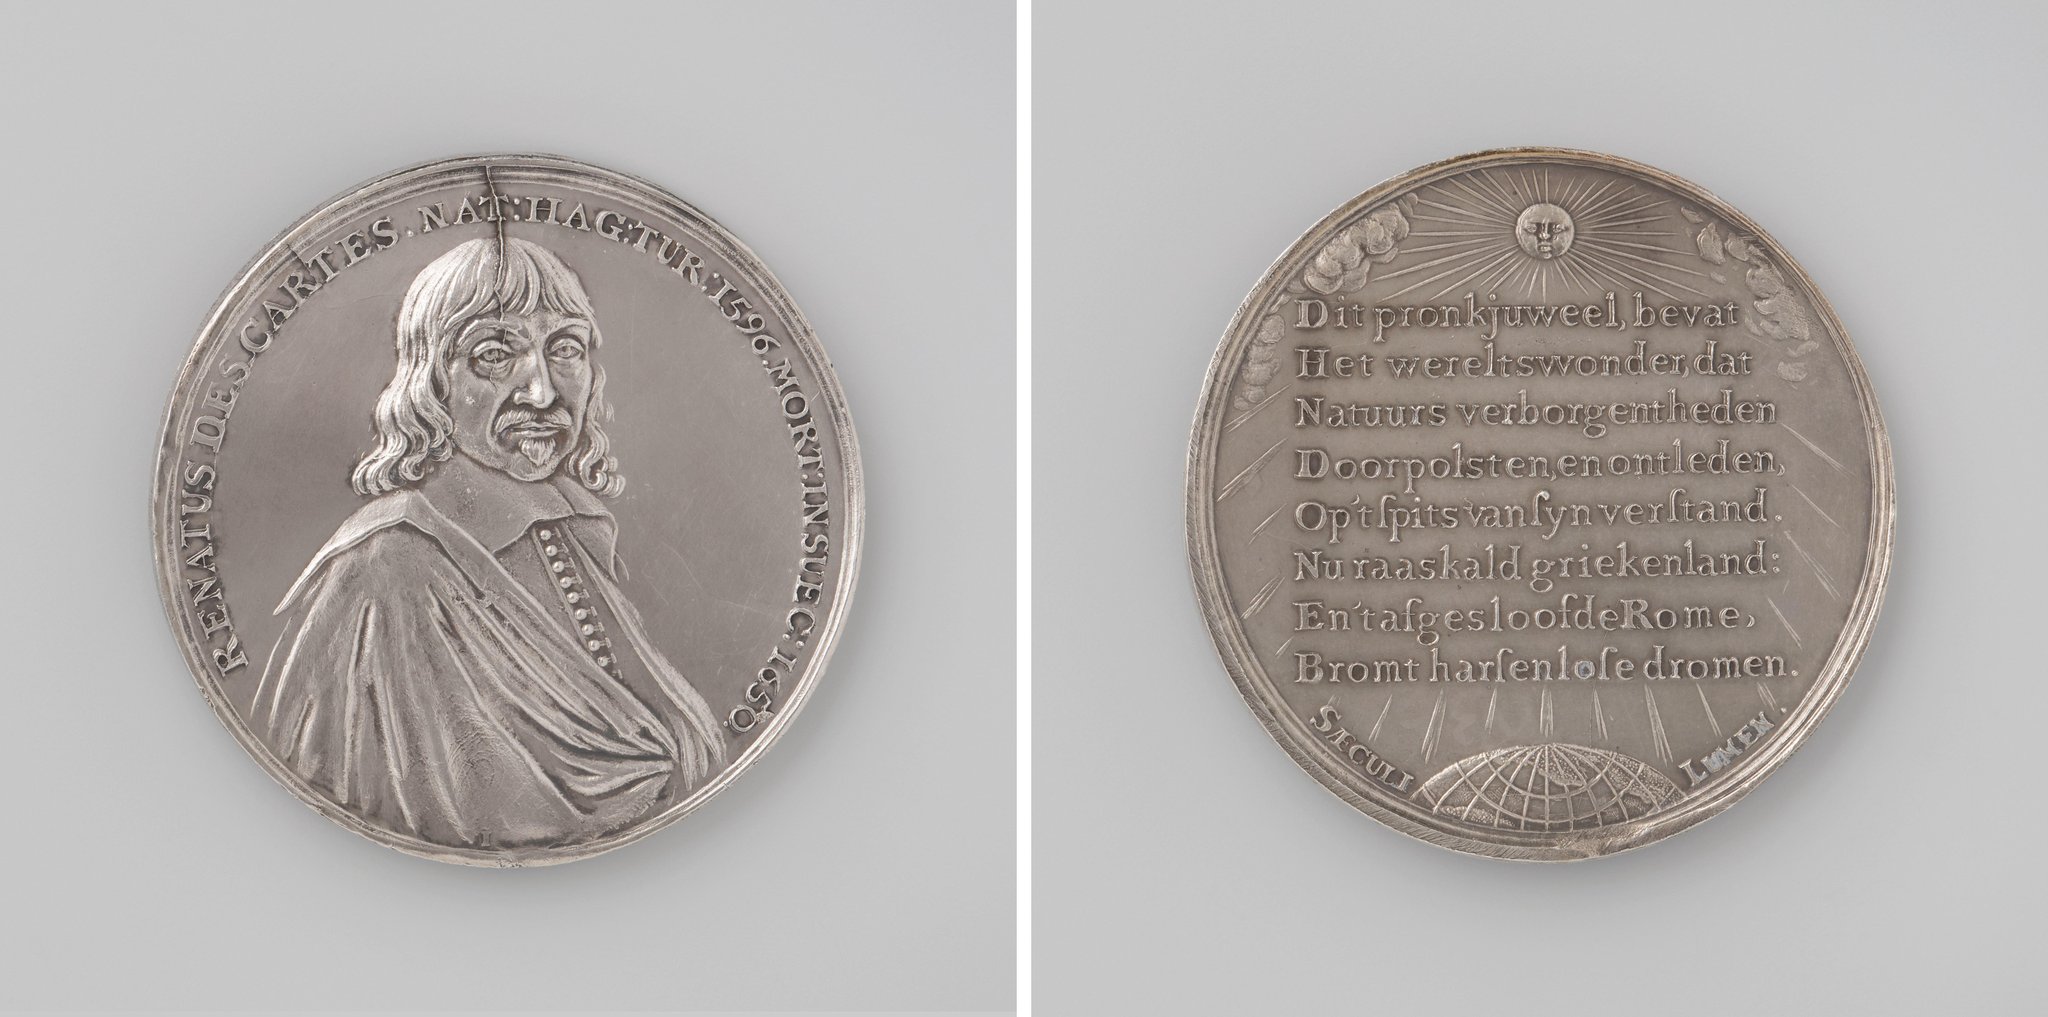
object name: history medal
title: Dood van Rene Descartes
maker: jan smeltzing (i)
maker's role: modelleur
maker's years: 1656-1693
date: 1669-1693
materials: silver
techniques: striking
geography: leiden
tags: rené descartes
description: Zilveren penning. Voorzijde: borststuk man binnen omschrift. Keerzijde: opschrift tussen stralende zon en globe